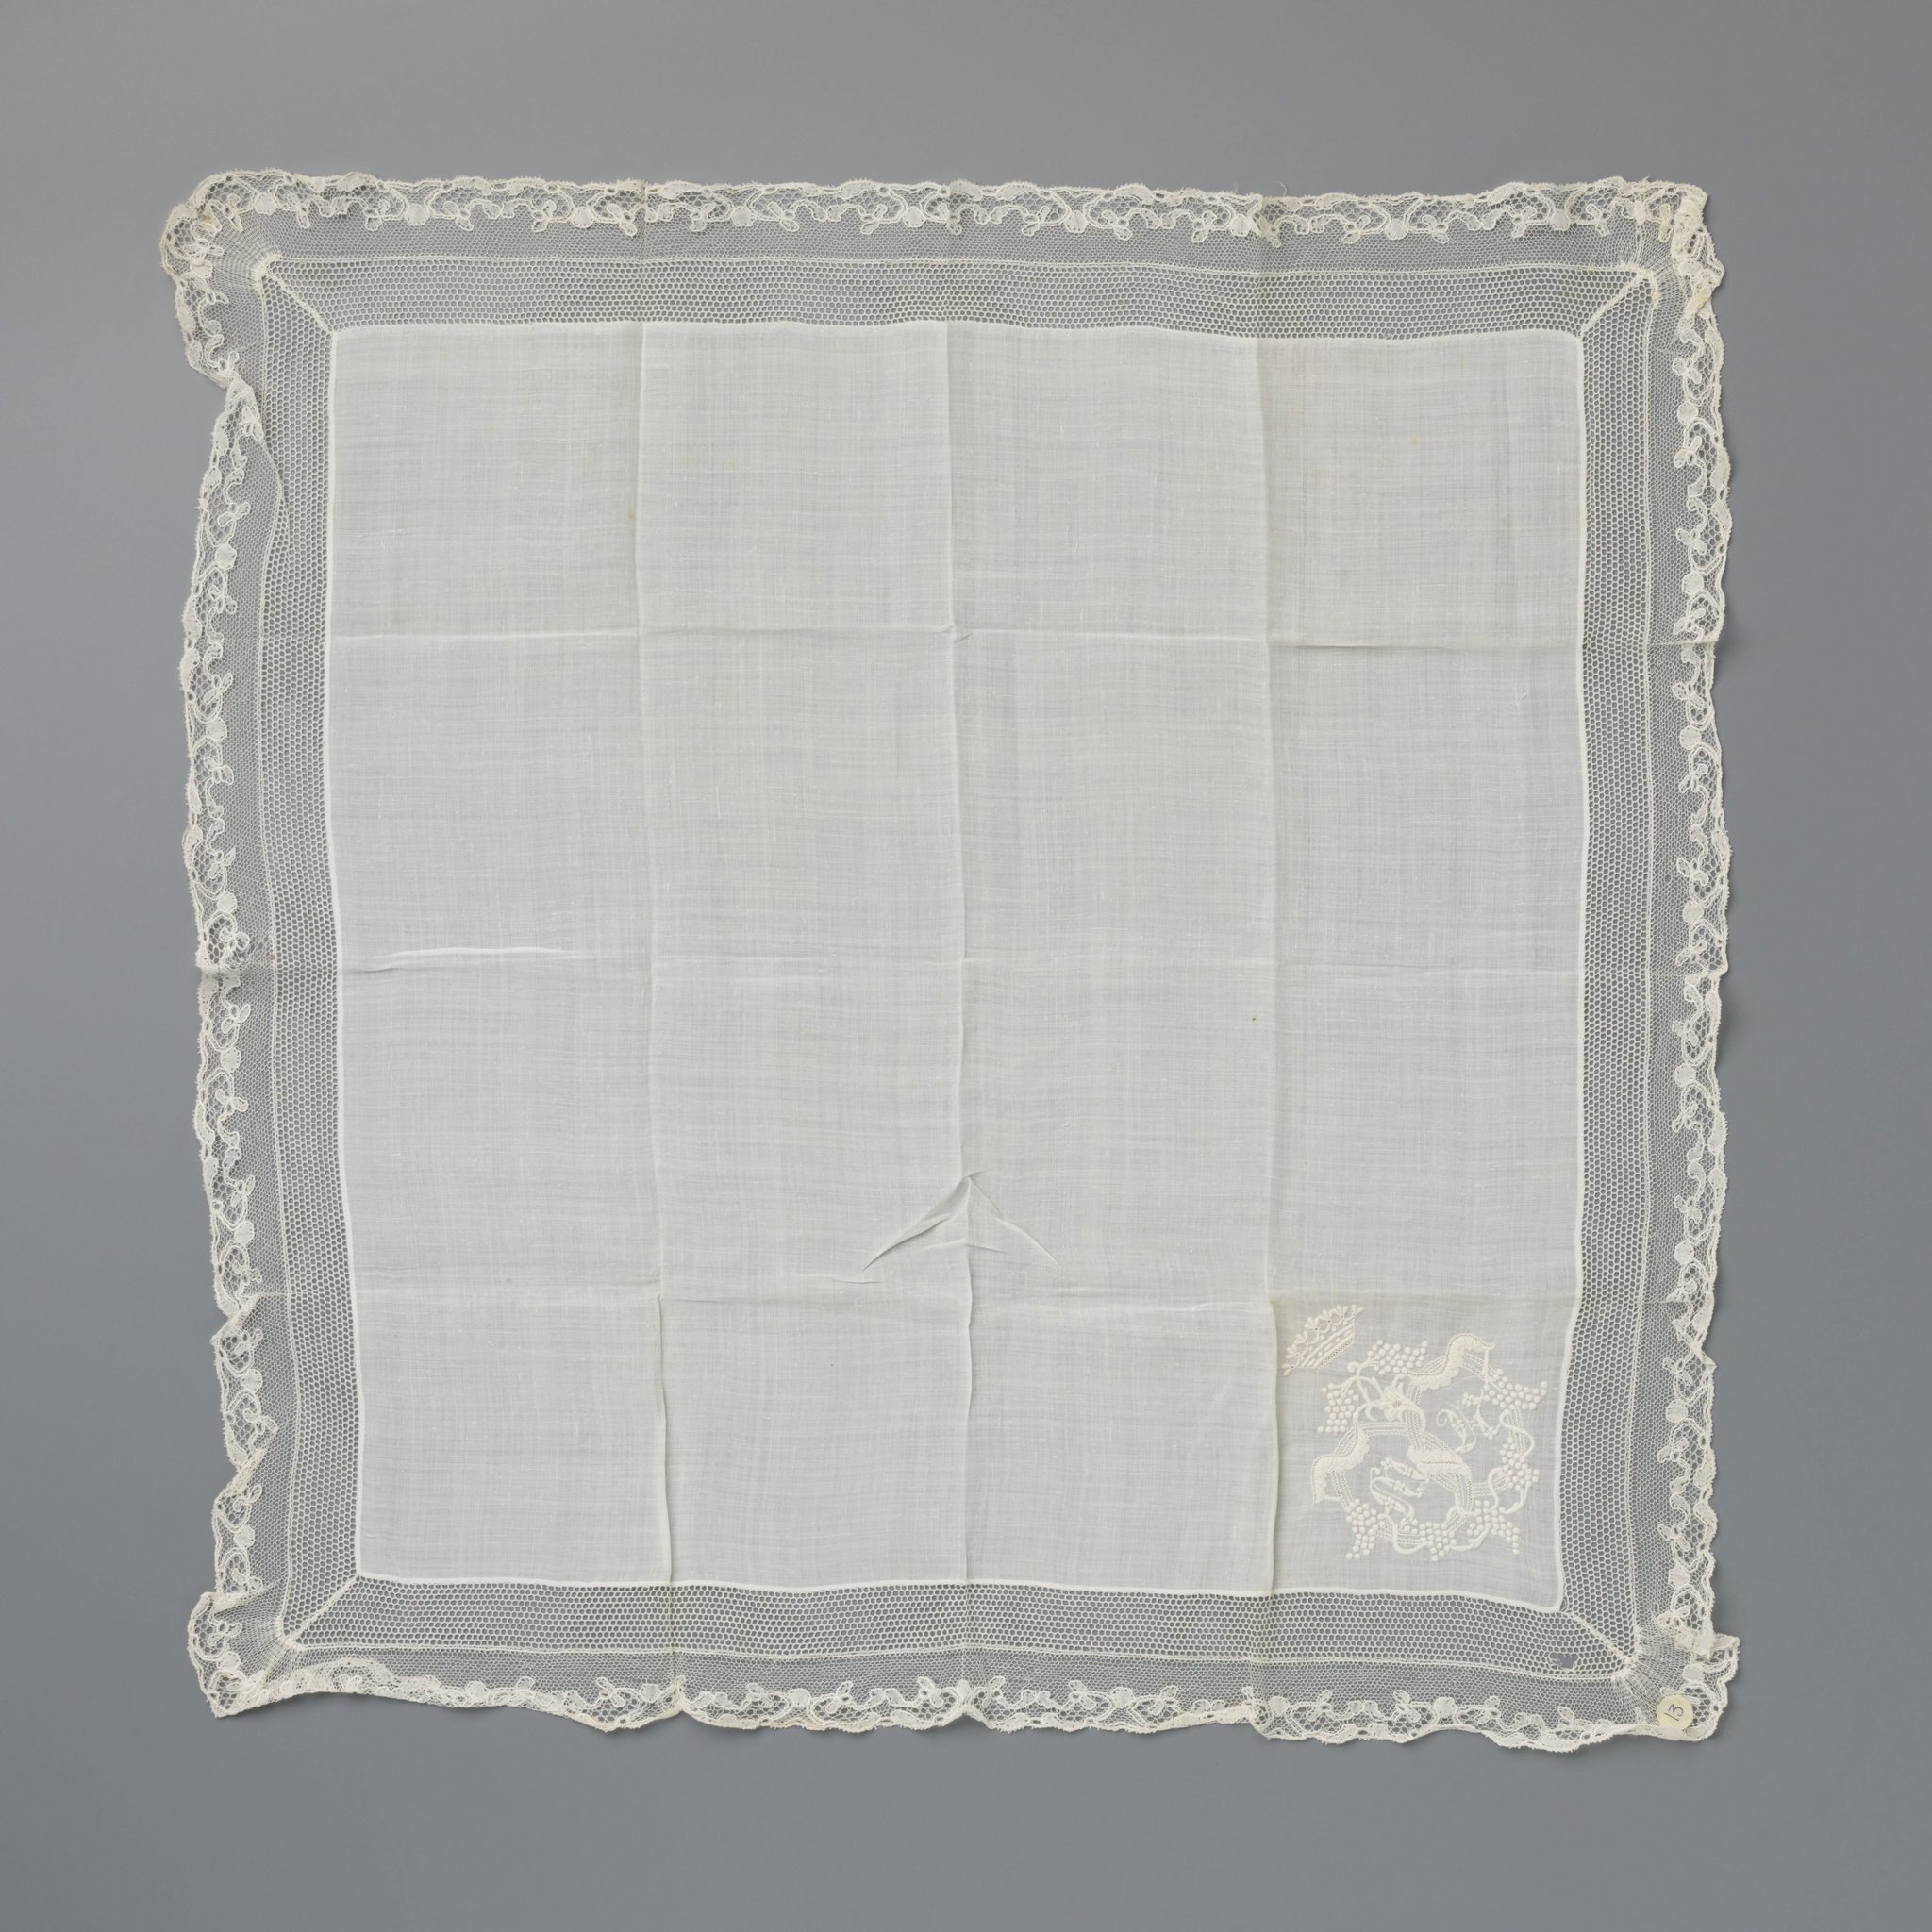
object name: handkerchief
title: Zakdoek van batist met geborduurde kroon boven de initialen MH en een rand machinale kant en kloskant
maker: Anonymous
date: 1840-1860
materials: cotton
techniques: lace, embroidered, weave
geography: netherlands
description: Zakdoek van naturelkleurige batist met een rand machinale kant en daar omheen een rand naturelkleurige kloskant: Rijselse-kant. Op één hoek van het batist is wit borduurwerk te zien: schuingeplaatst de initalen M en H. Elke letter staat in een apart ovaal cartouche, die in elkaar gehaakt zijn en versierd zijn met trosbloemen en gevederde bladeren. Boven de versierde initialen staat een kroontje. De zakdoek is rond het batist afgezet met een rand machinale kant, een onversierde machinale traliegrond. De direct hieraan bevestigde buitenrand is gemaakt van kloskant, met een zich herhalend patroon van twee naar elkaar toegewende en platgedrukte c-motieven. De motieven zijn gemaakt in linnenslag en zijn voorzien van dikkere en glimmende contourdraden. Binnen de c-motieven is een siergrond toegepast, een rozengrond. De flauwe schulpenrand is afgewerkt met picots. De rand kloskant is met uitzondering van de gerimpelde hoeken glad aan de zakdoek gezet.